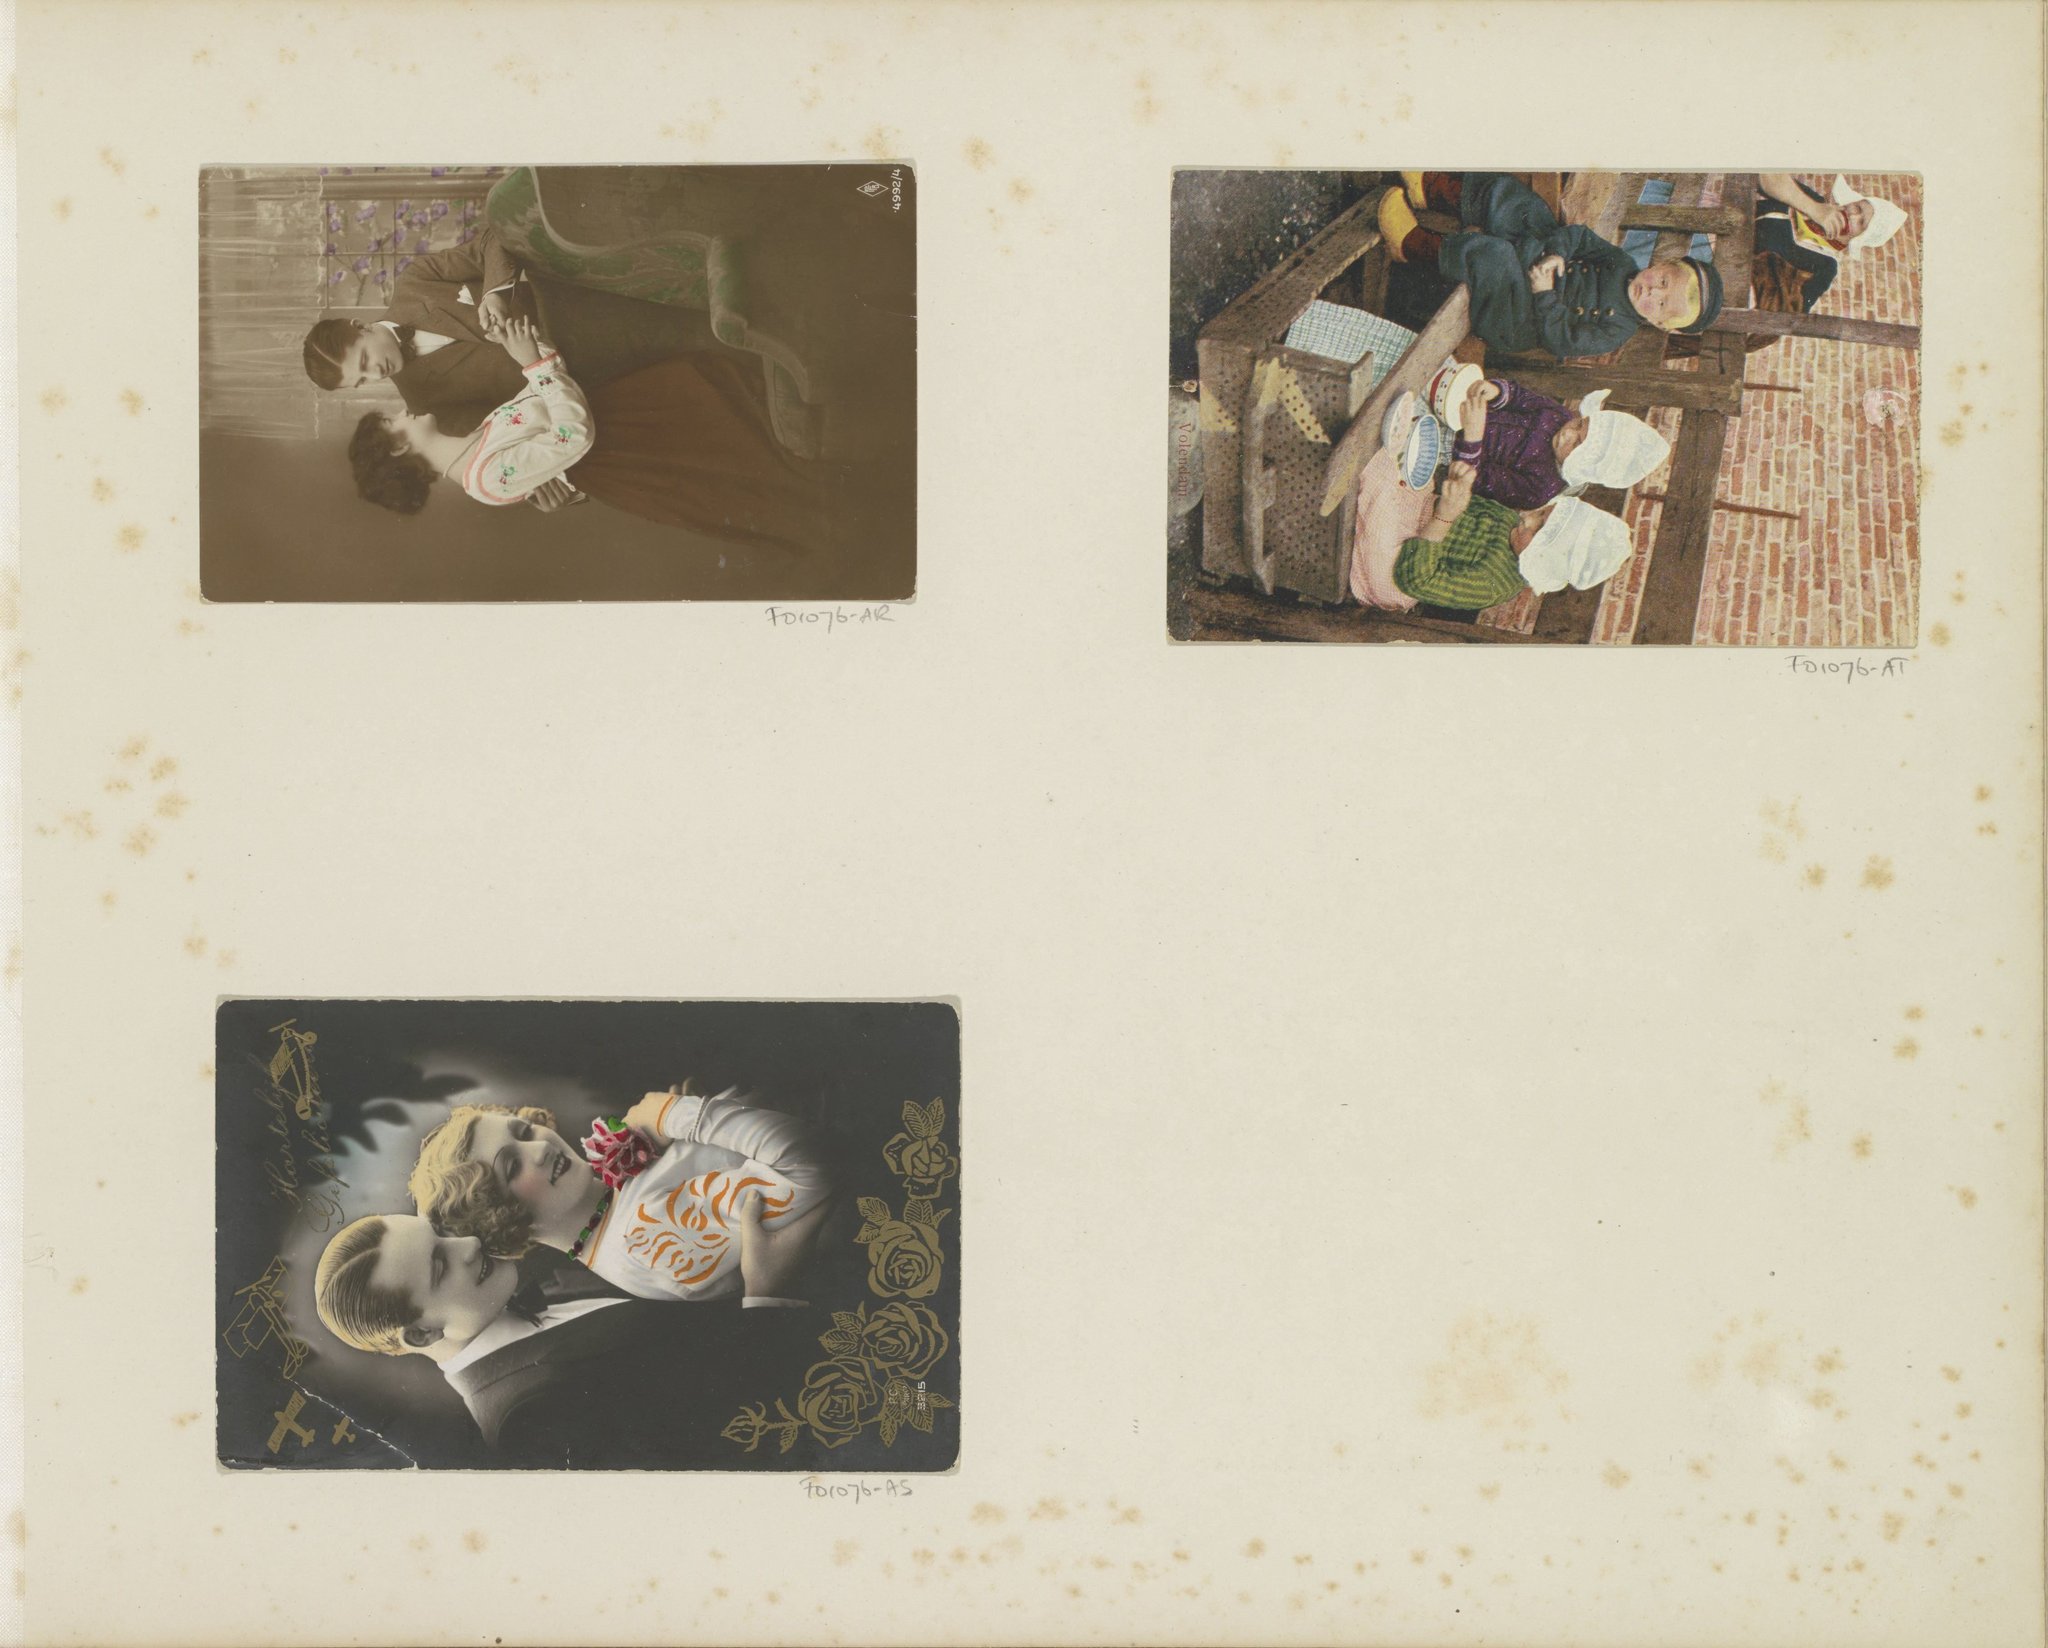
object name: ansichtkaart, prentbriefkaart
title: Portret van twee geliefden bij een fauteuil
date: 1900-1910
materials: cardboard, paper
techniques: gelatin silver print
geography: berlin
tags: couple of lovers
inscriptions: number: ‘4992/4’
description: Onderdeel van Album met foto's van spoorwegen in Nederlands-Indië en prentbriefkaarten.